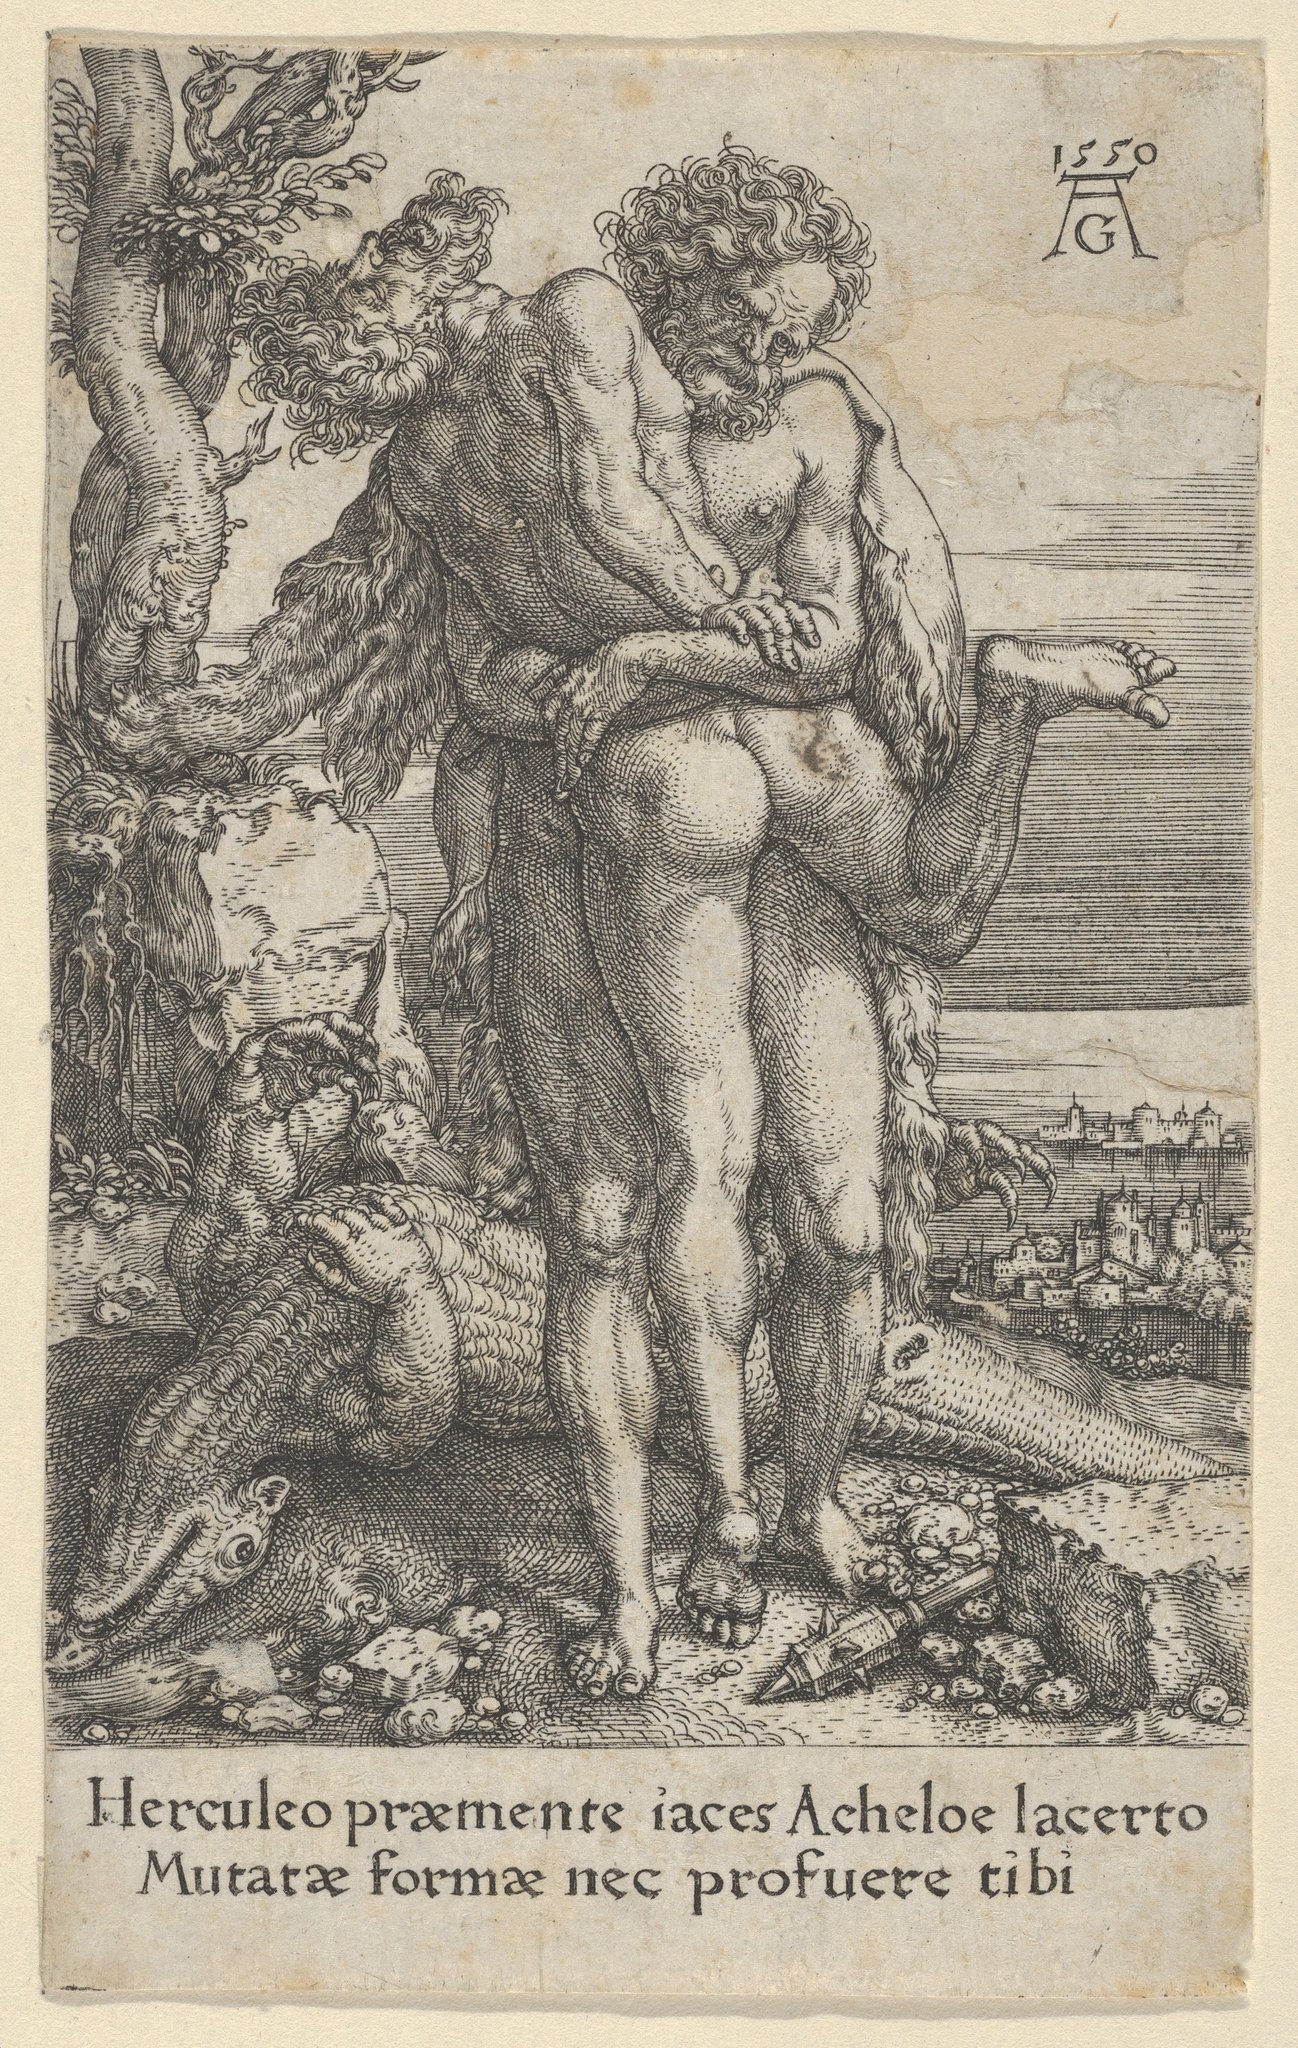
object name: print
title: Hercules Fighting the River-God Achelous, from "The Labors of Hercules"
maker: heinrich aldegrever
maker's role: artist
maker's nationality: german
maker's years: 1502-1561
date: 1550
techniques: engraving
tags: male nudes,hercules,crocodiles